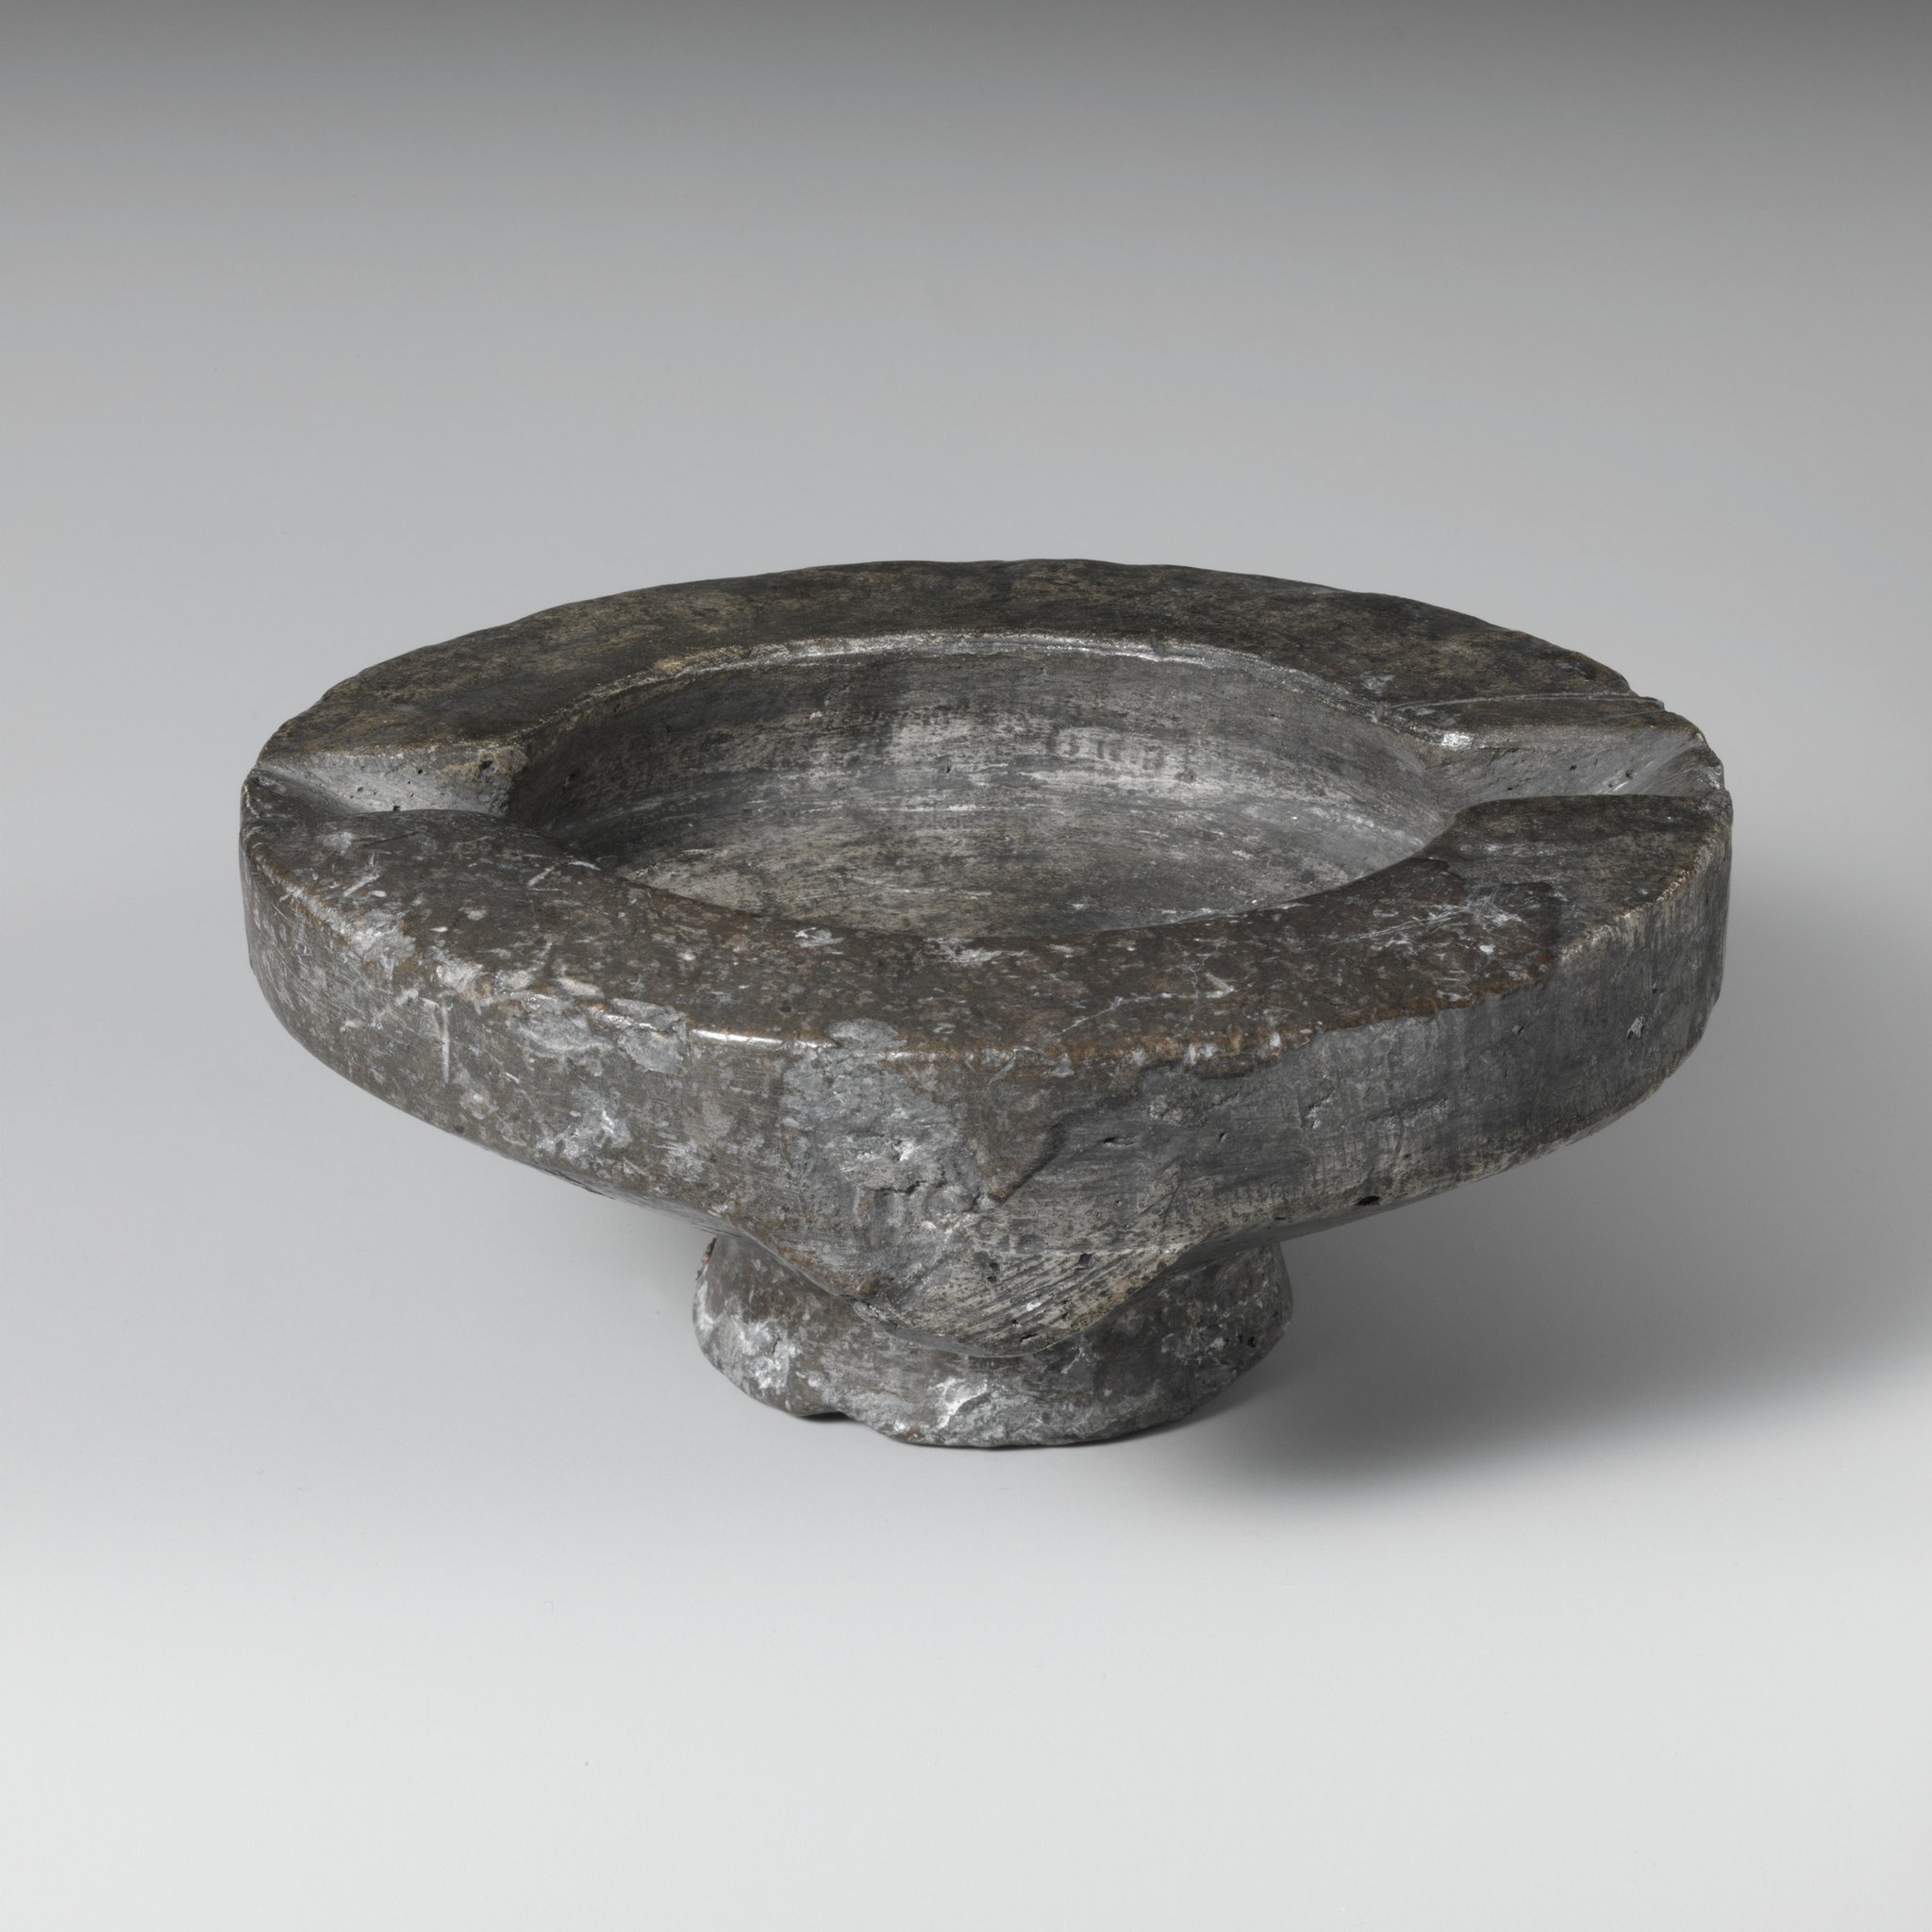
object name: lamp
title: Steatite oil lamp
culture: minoan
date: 1750-1450 BCE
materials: stone